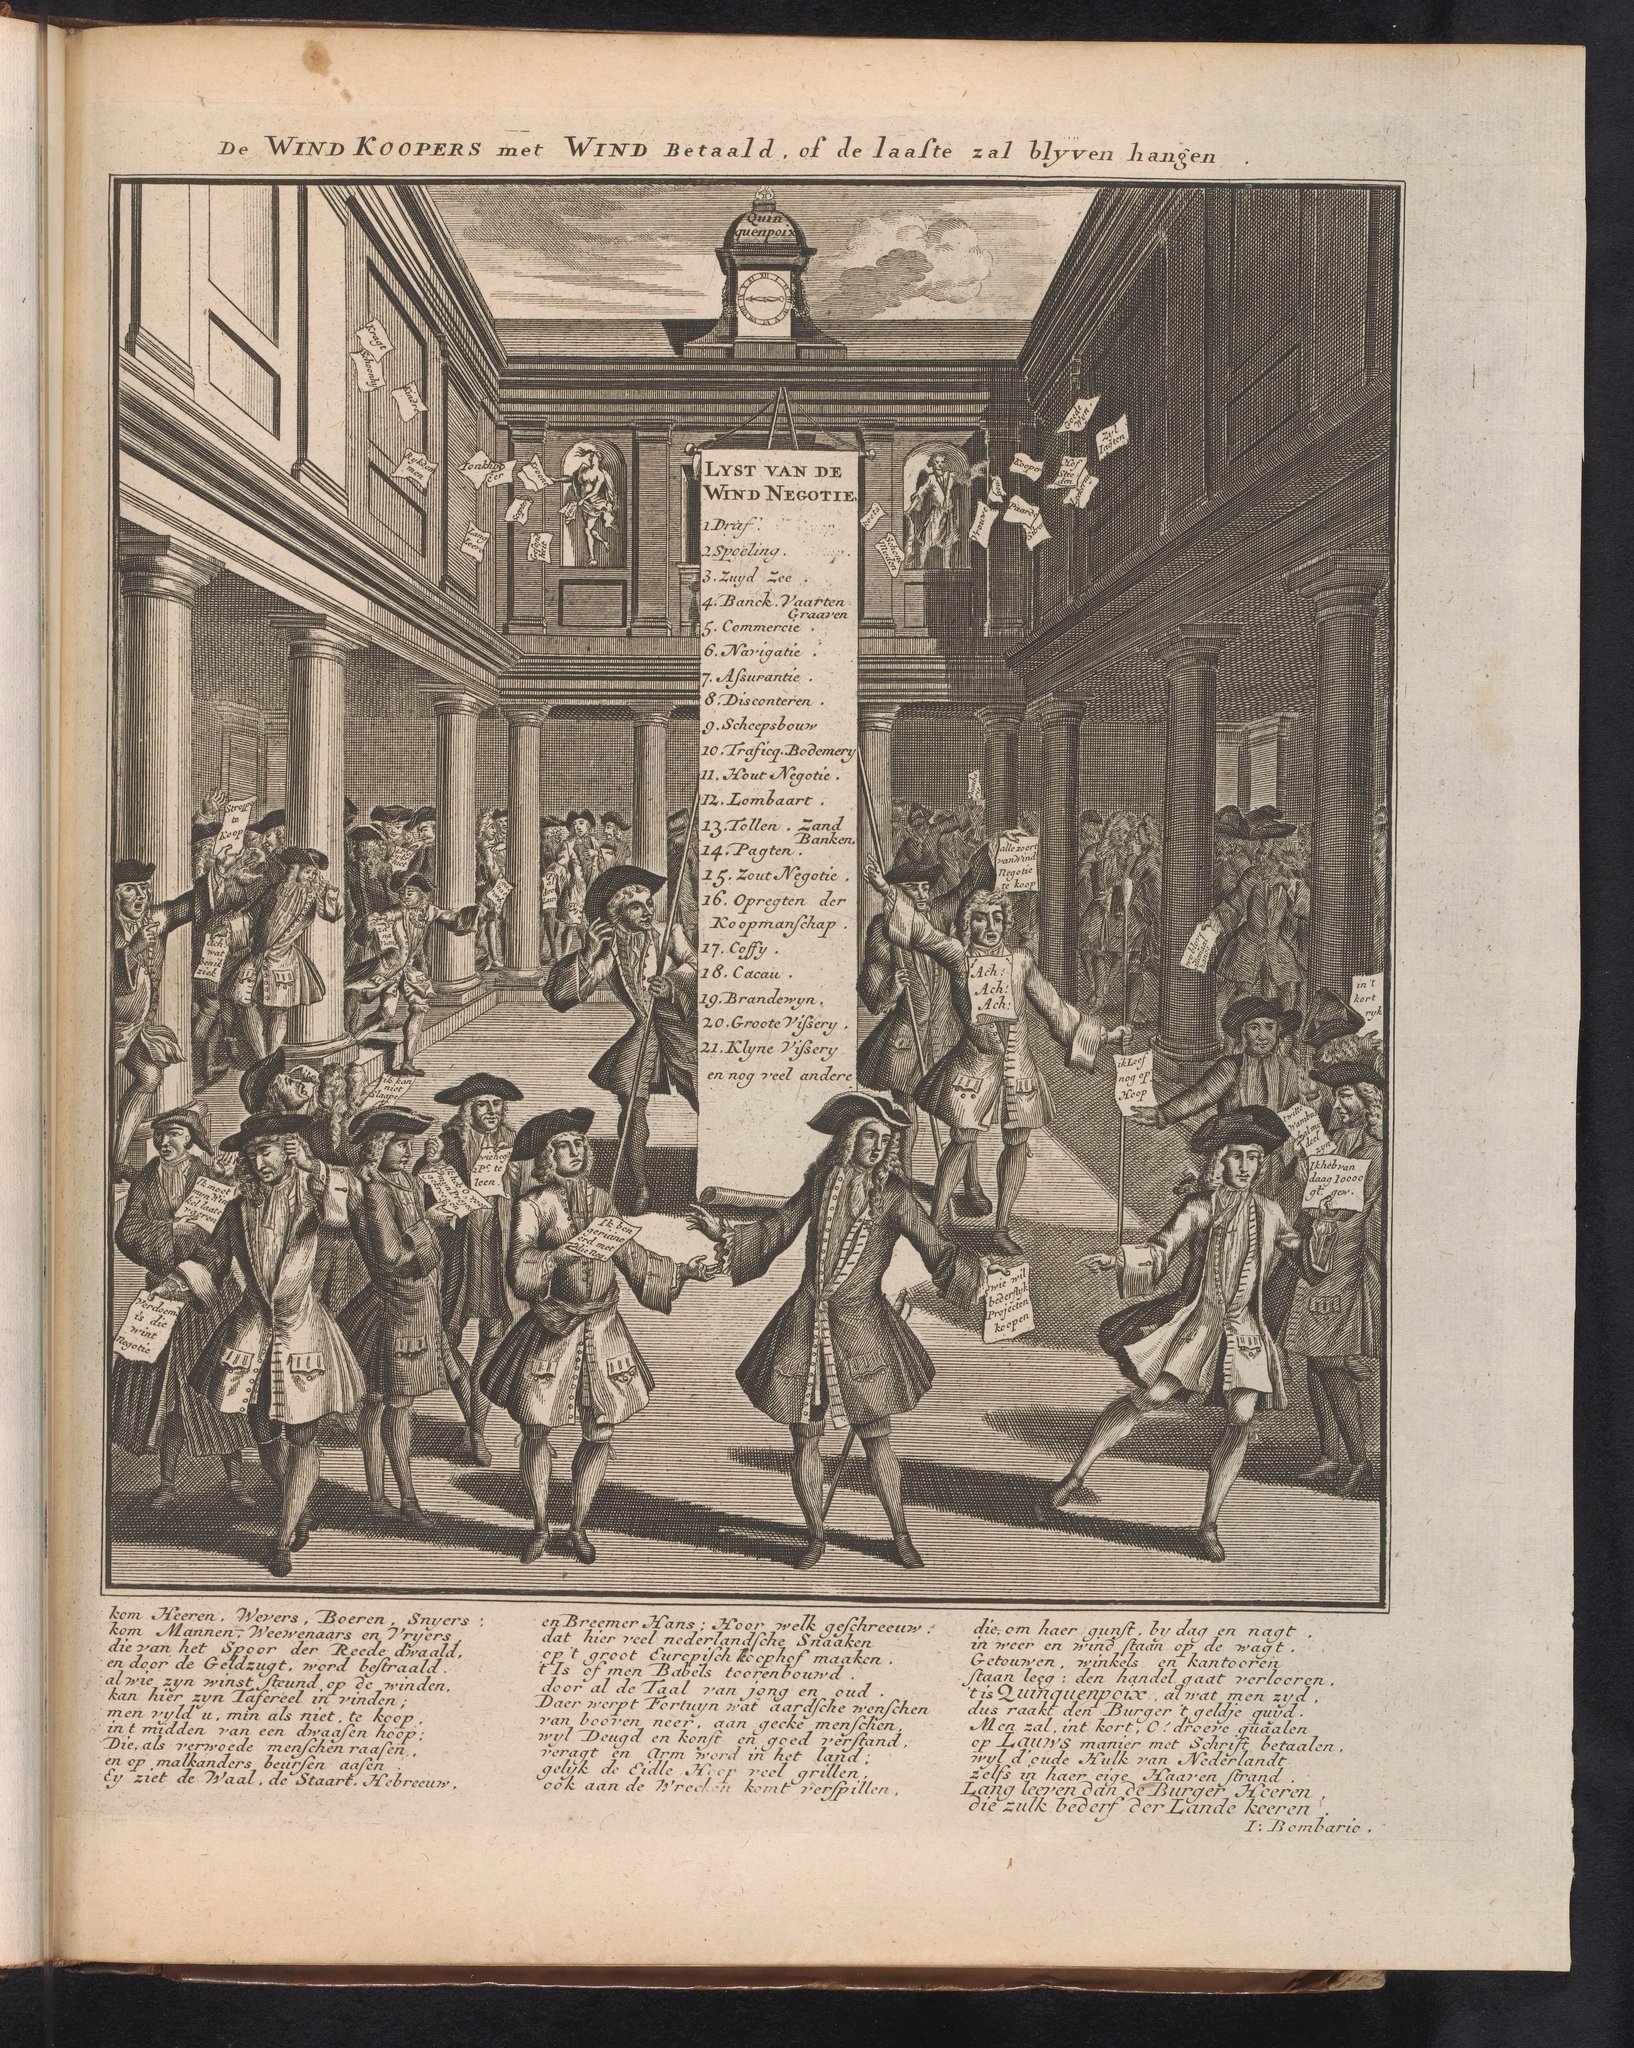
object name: print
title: Wanhopige handelaren in de beurs van Amsterdam, 1720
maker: Anonymous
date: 1720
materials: paper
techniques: engraving, etching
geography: northern netherlands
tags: financial panic, stock exchange, stock-market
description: Wanhopige handelaren, slachtoffers van de windhandel, op de binnenplaats van de beurs van Amsterdam, 1720. In het midden hangt een lijst met de producten van de windnegotie. In het onderschrift een vers in drie kolommen door I. Bombarie. Prent in de gebonden eerste uitgave (304 B 11) van Het Groote Tafereel der Dwaasheid met spotprenten op de Windhandel of Actiehandel van 1720.